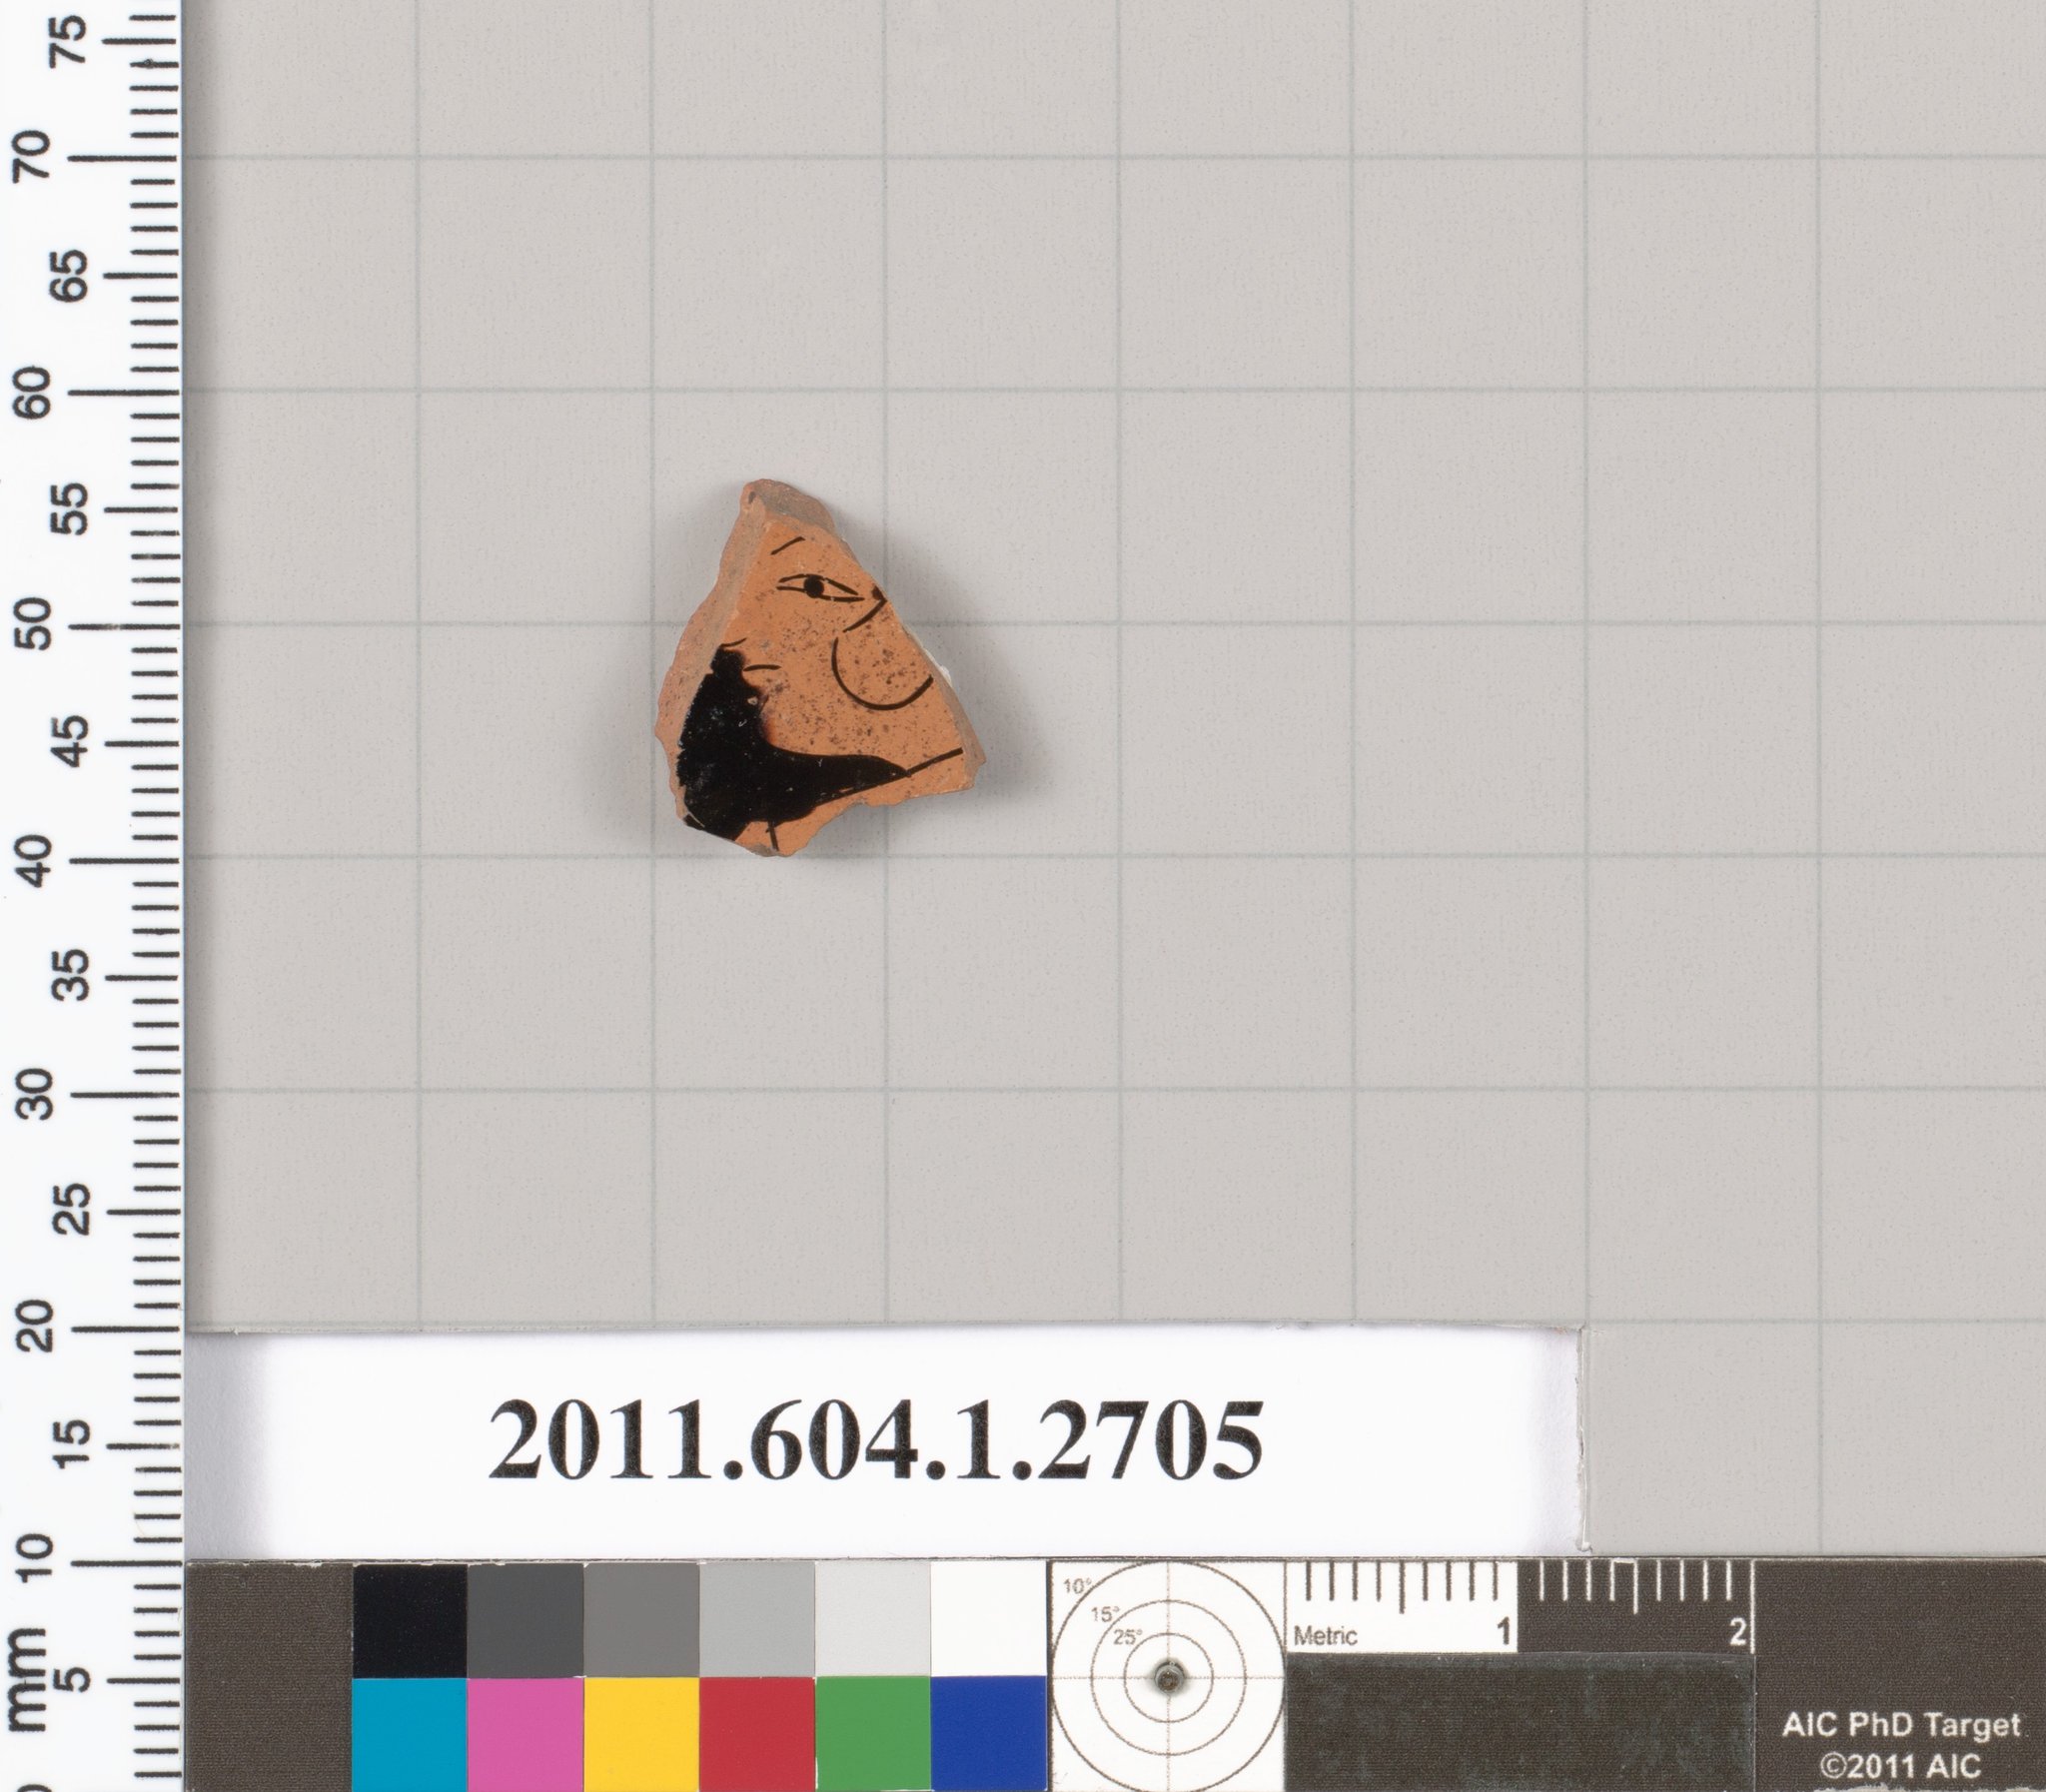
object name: kylix fragment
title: Terracotta fragment of a kylix (drinking cup)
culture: greek, attic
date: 520-500 BCE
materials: terracotta